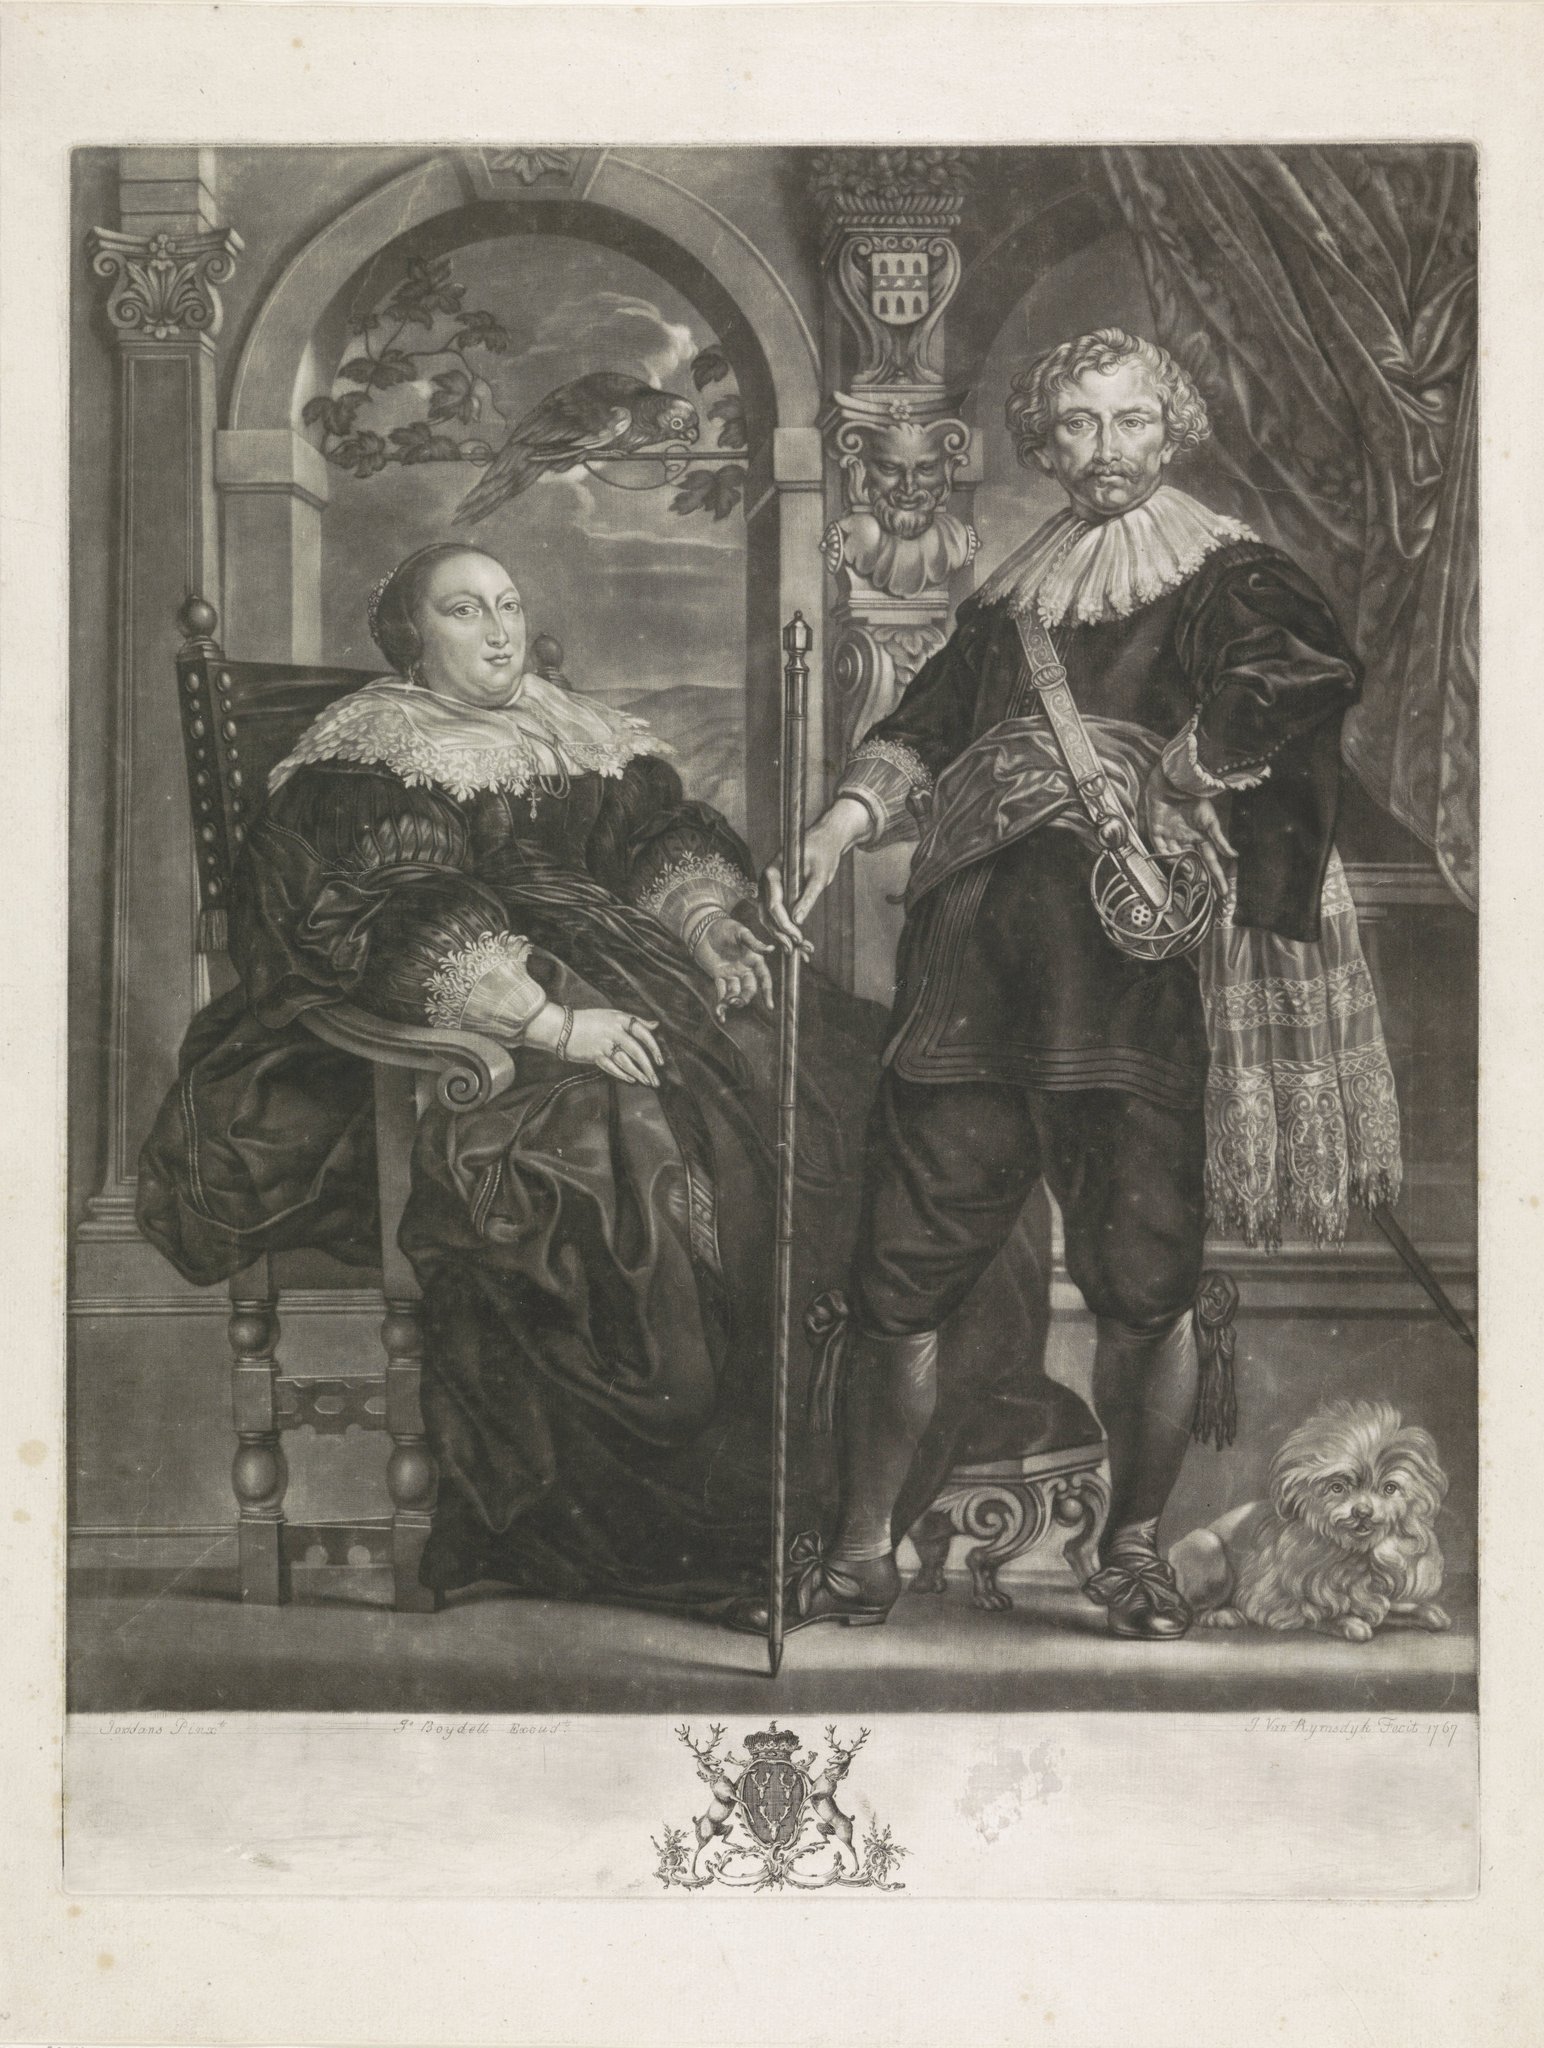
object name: print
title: Portret van Frederik Hendrik en Amalia van Solms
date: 1767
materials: paper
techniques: etching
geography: bristol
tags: frederick henry (prince of orange), the hague, amalia of solms-braunfels, ornamental birds: peacock, armorial bearing, heraldry, dog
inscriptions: collector's mark: Lugt 240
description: Frederik Hendrik, prins van Oranje met zijn vrouw Amalia van Solms. Naast de prins zit een hondje en op de achtergrond zit een papegaai.